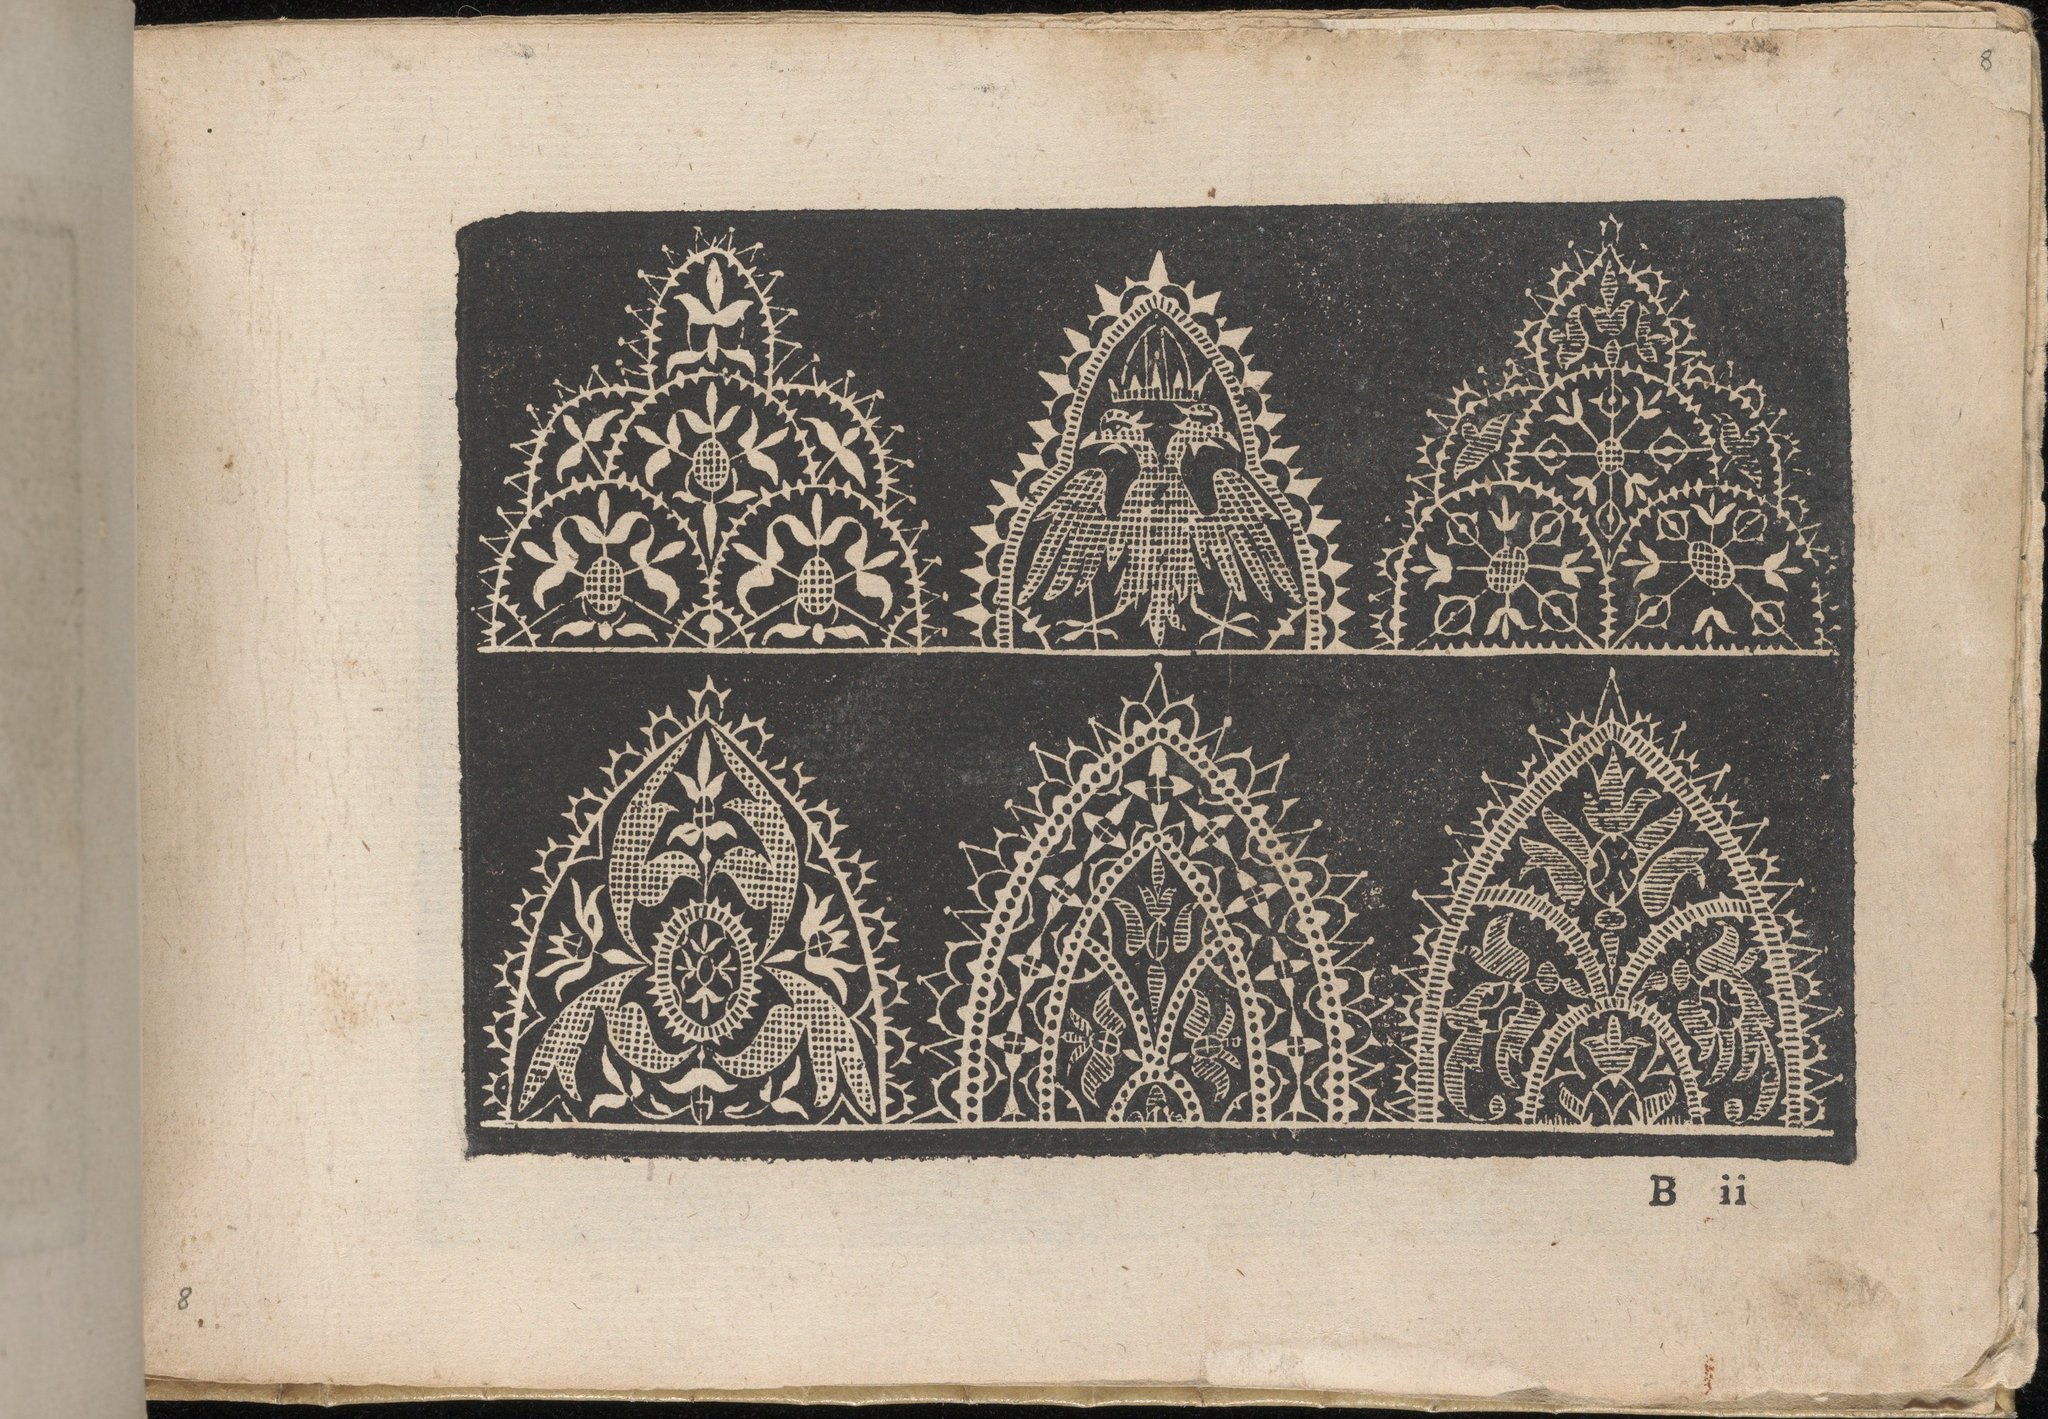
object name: book print ornament archiecture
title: Fiori di Ricami Nuovamente Posti in Luce, page 8 (recto)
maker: matteo florimi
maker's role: designer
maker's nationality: italian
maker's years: 1581-1613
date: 1591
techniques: woodcut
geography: italy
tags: flowers